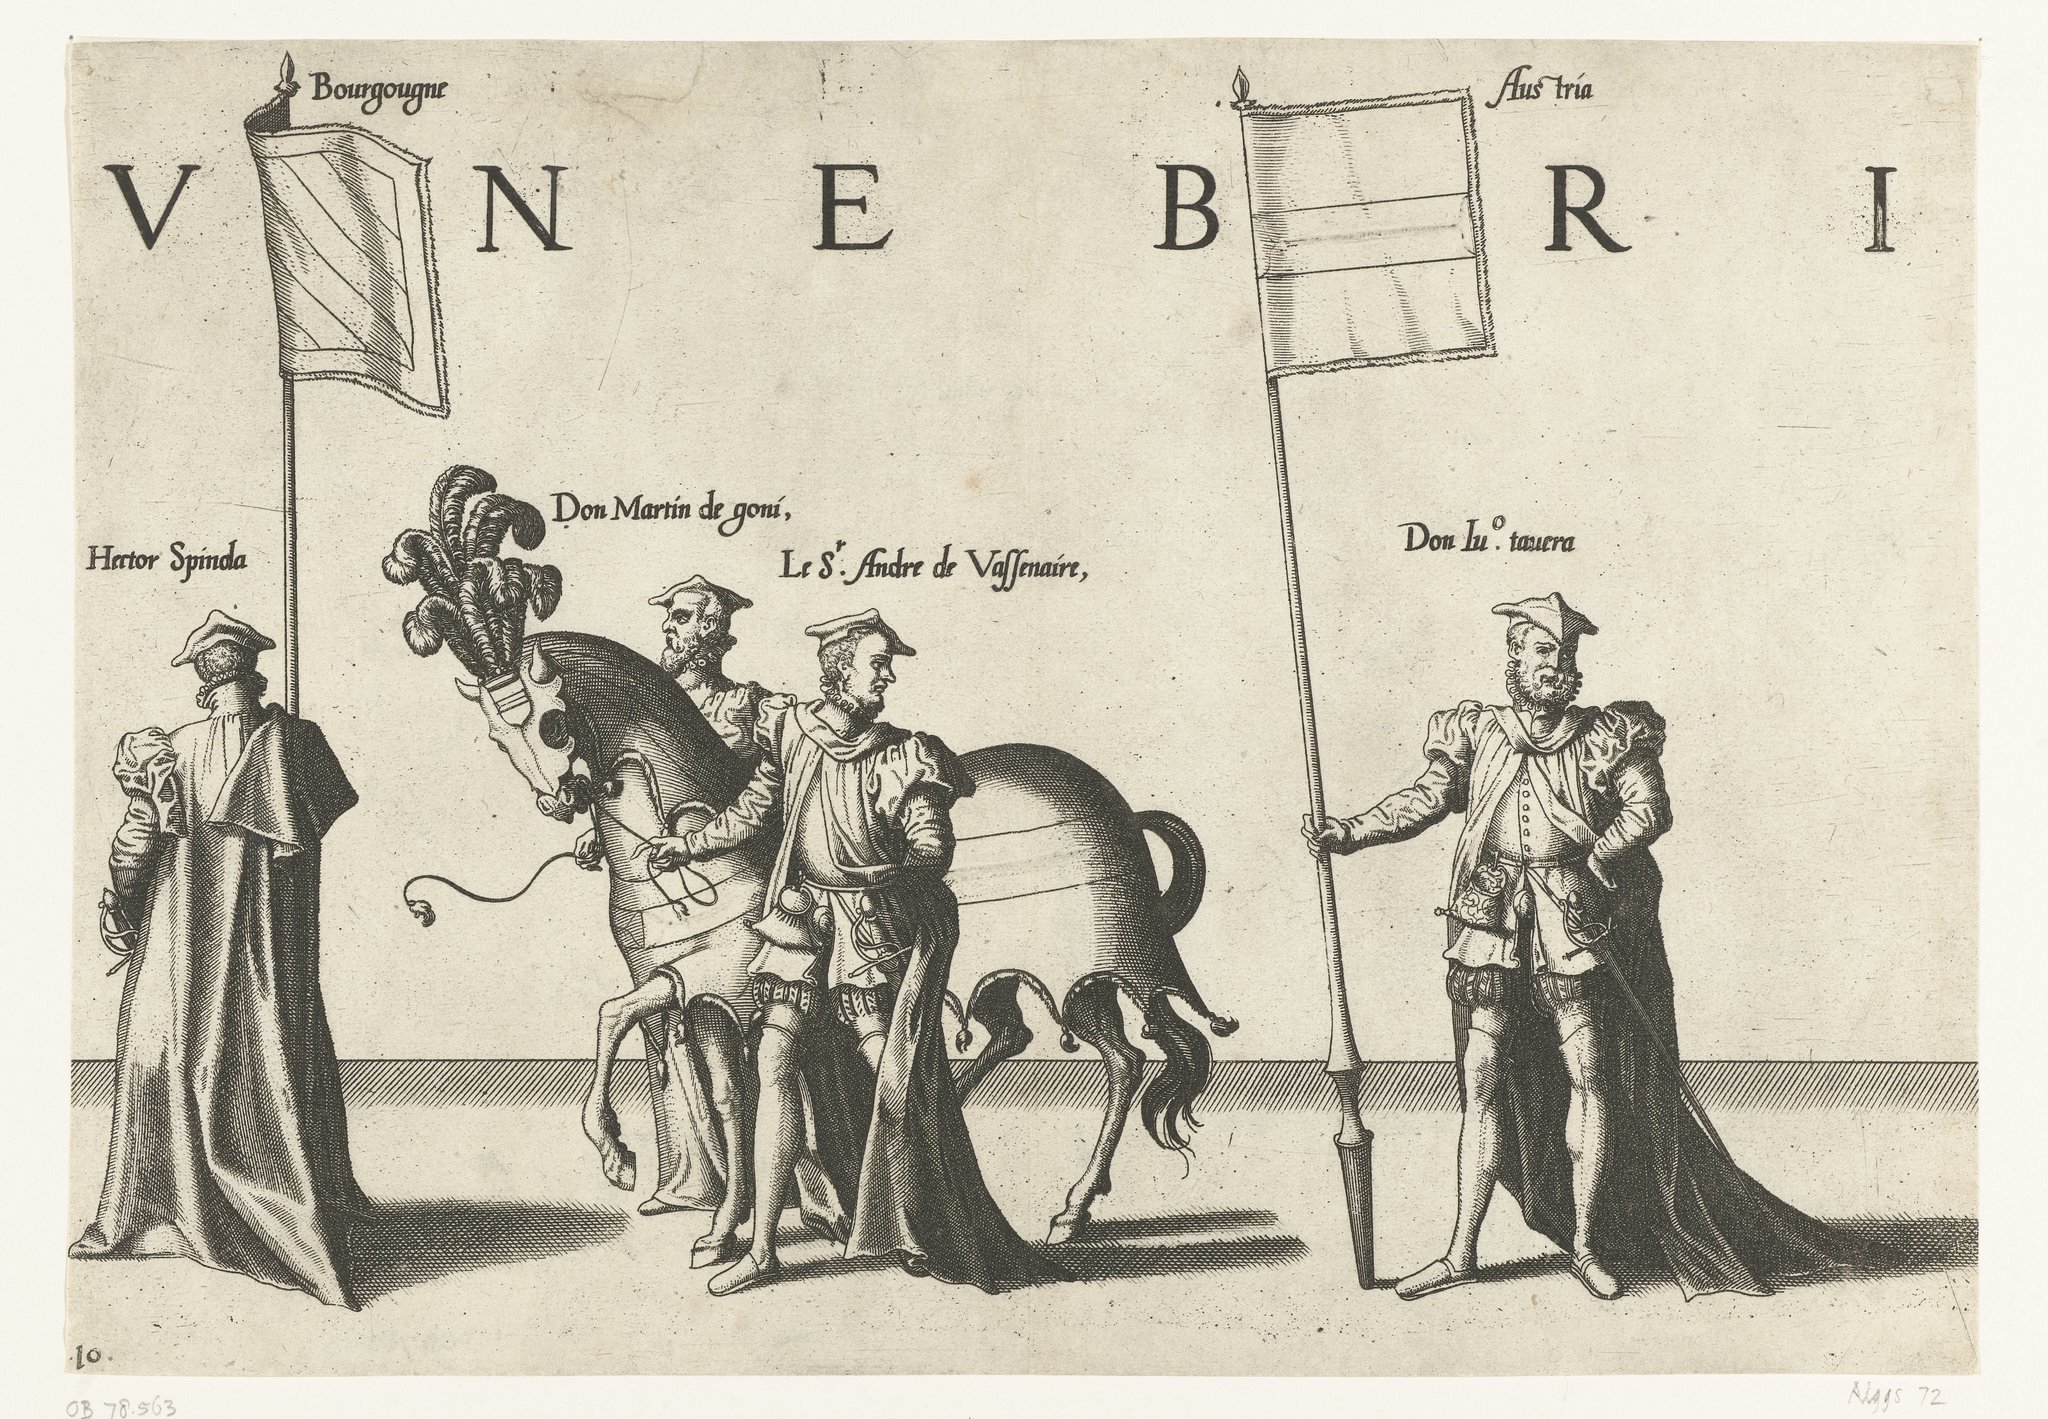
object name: print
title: La magnifique, et sumptueuse Pompe Funebre, faite aus Obseques & Funerailles du tres-grand & tres-victorieus Empereur Charles Cinquième, Celebrées en la Vile de Bruxelles le XXIX. Iour du Mois de Decembre M.D.LVIII. par Philippes Roy Catholique d'Espaignes son Fils.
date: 1559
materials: paper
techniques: engraving, etching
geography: southern netherlands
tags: charles v (holy roman emperor and king of spain), cortege, funeral procession, austria, brussels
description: Vier deelnemers aan de optocht, een paard en de vaandels met de wapens van Bourgondië en Oostenrijk. Onderdeel van de prentreeks van de Begrafenisoptocht van keizer Karel V op 29 december 1558 te Brussel.